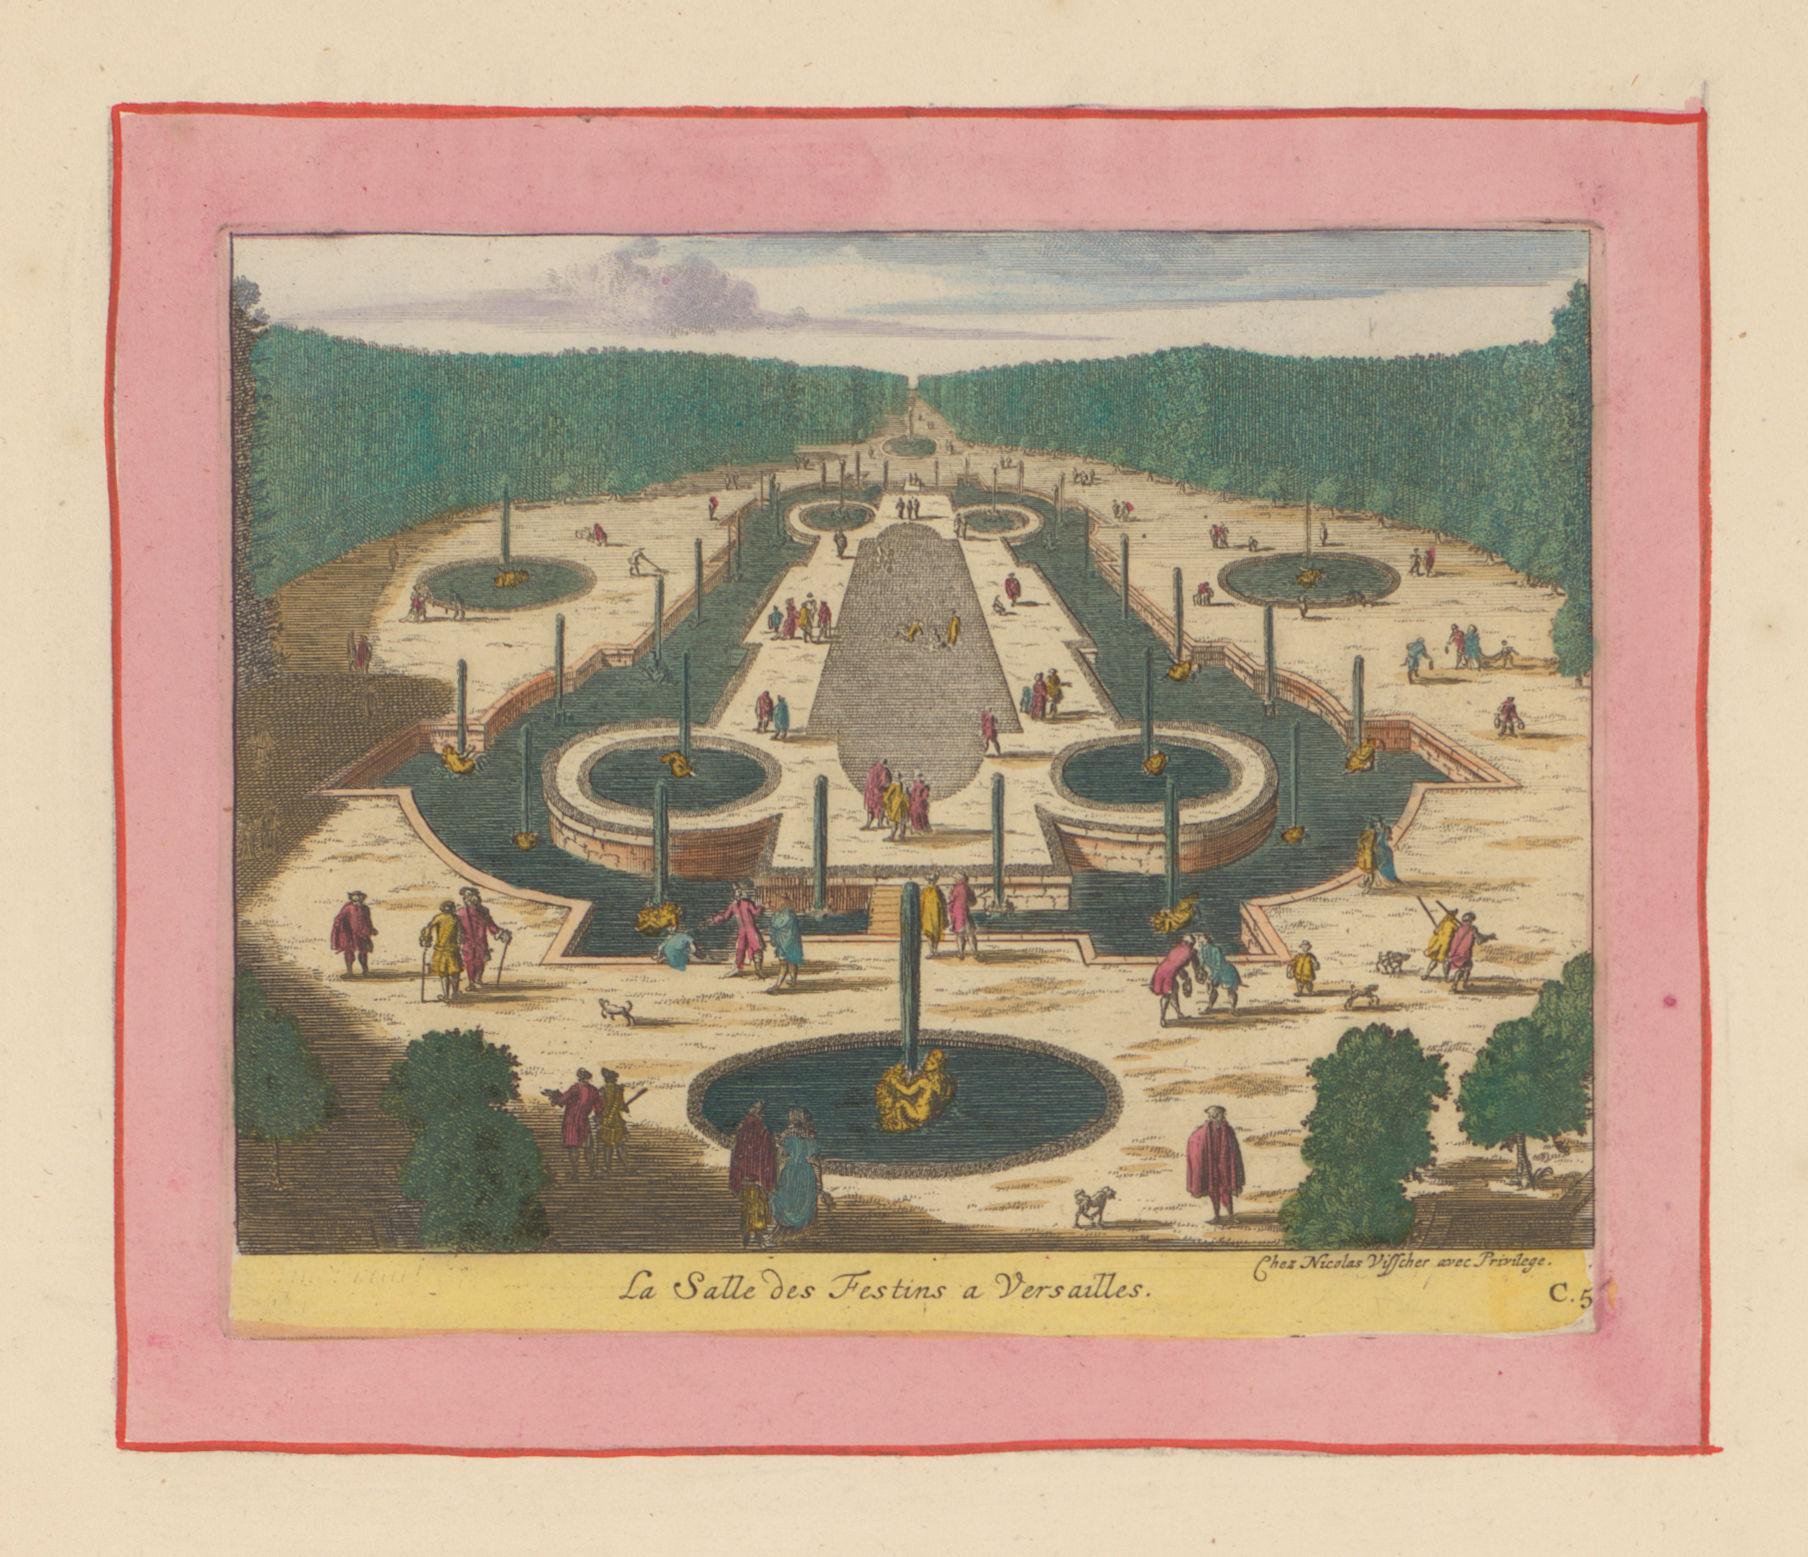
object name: print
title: Salle des Festins in de tuinen van Versailles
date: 1686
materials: paper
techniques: etching, hand coloring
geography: amsterdam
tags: garden fountain, french or architectonic garden; formal garden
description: De prent maakt deel uit van een serie bestaande uit 87 genummerde prenten (volgens Hollstein). De serie is opgedeeld in de delen A t/m F.